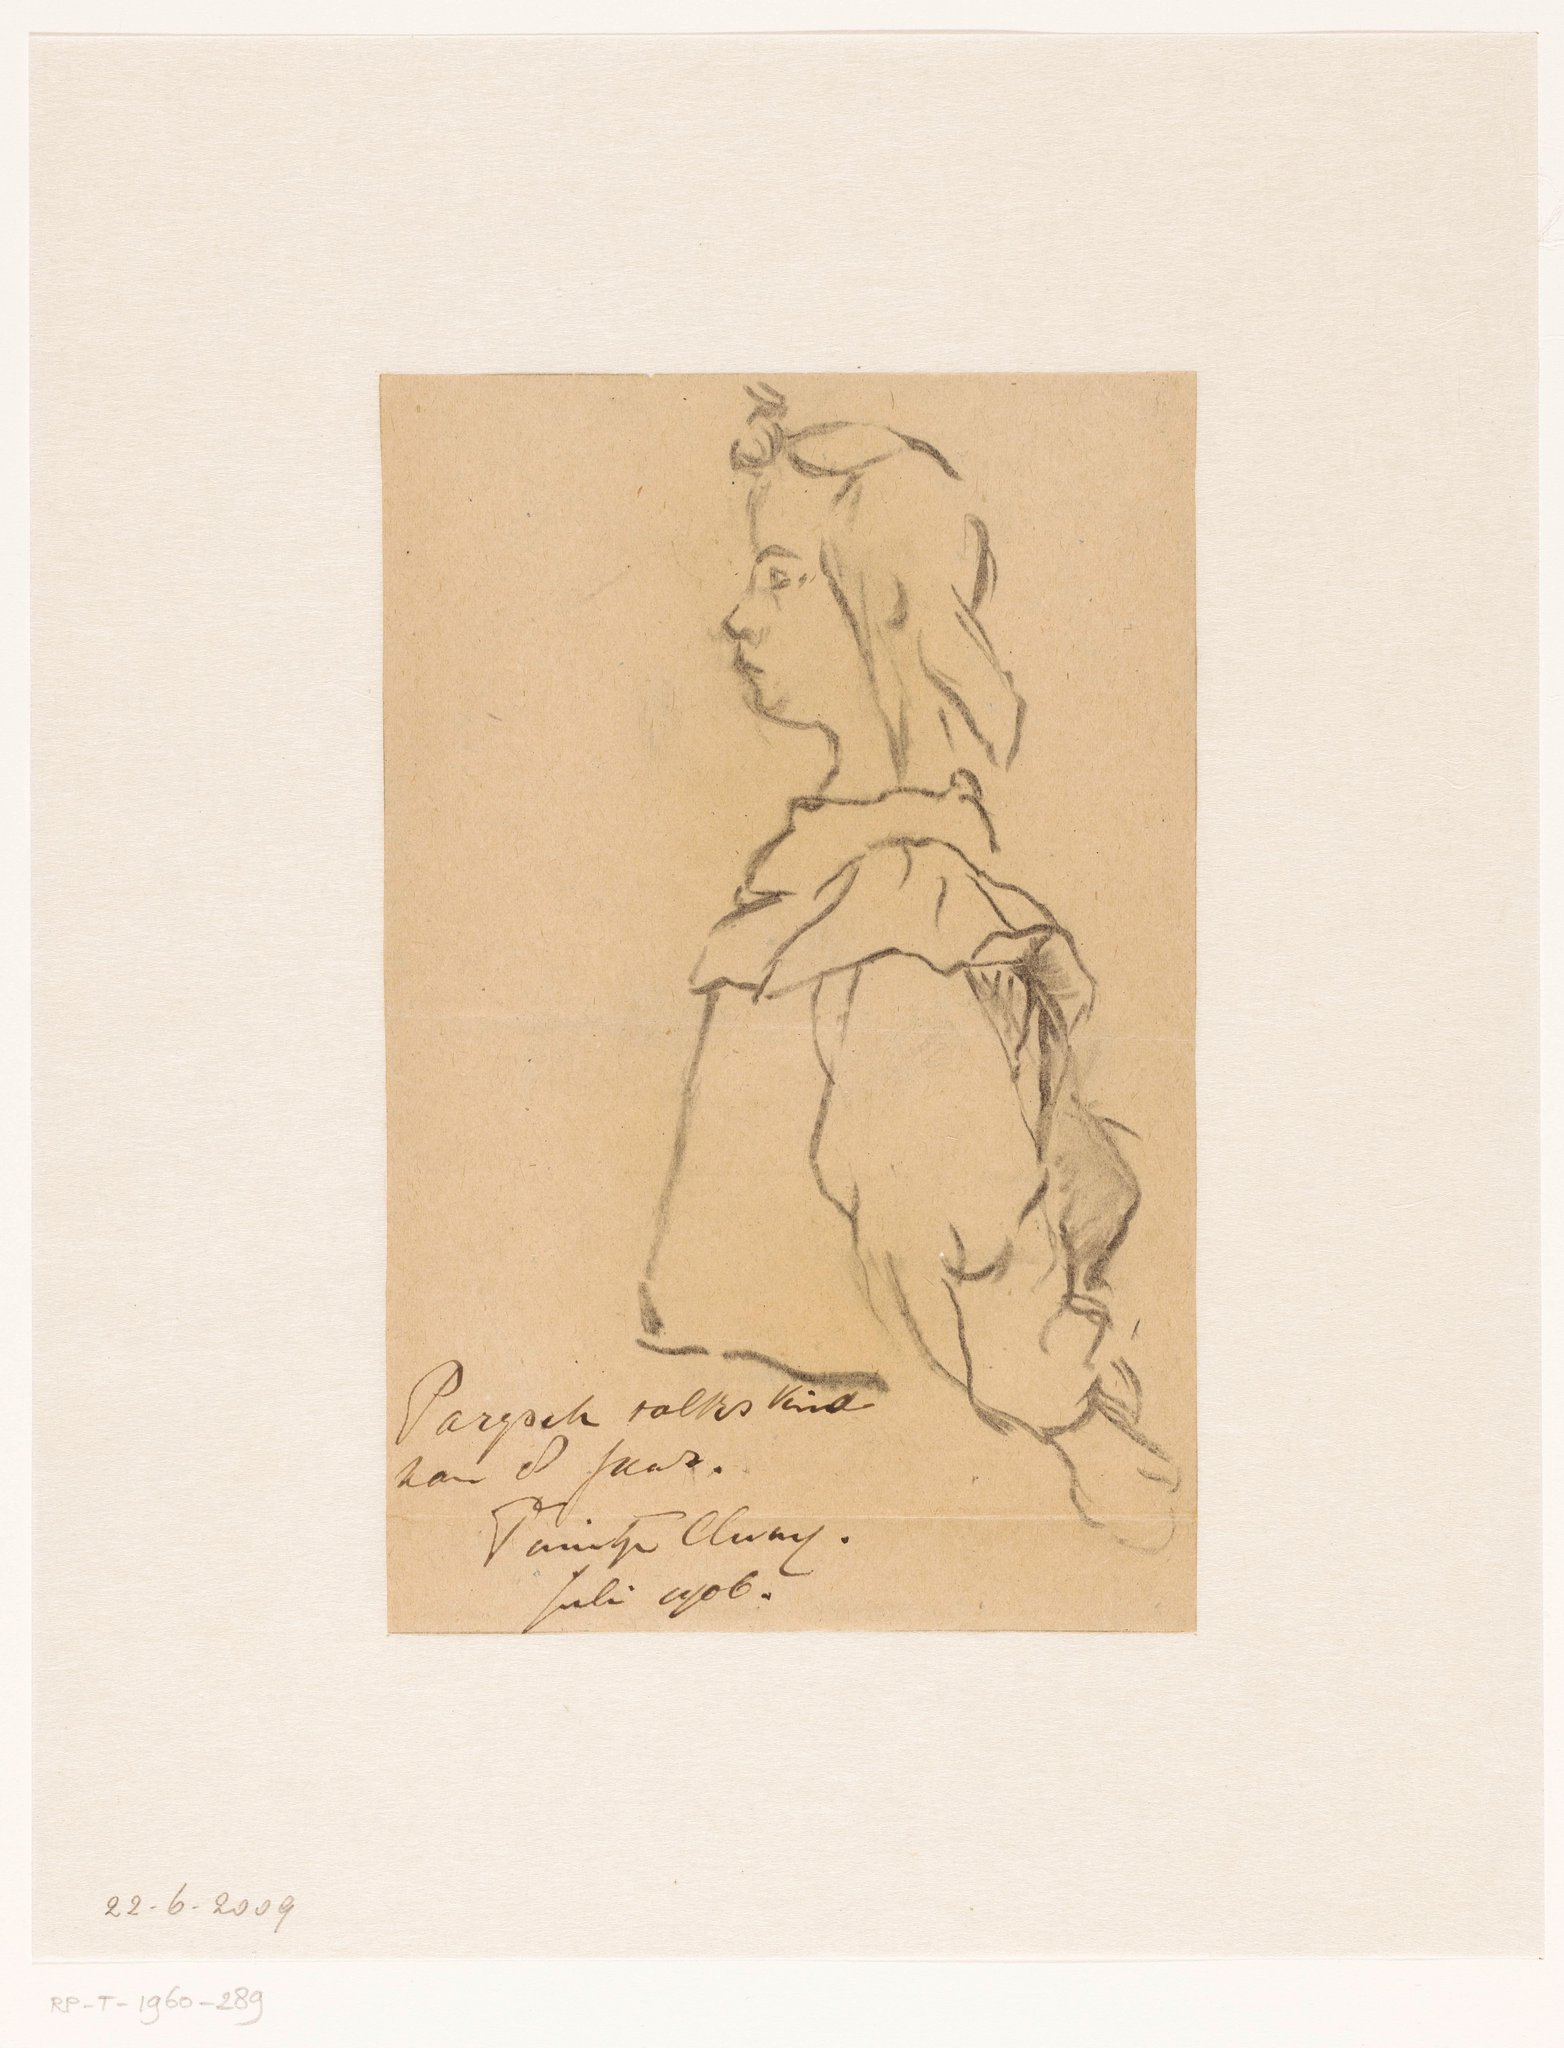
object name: drawing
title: Parijs volkskind van acht jaar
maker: carel nicolaas storm van s-gravesande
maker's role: draughtsman, print maker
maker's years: 1841-1924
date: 1906-1907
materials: charcoal, paper